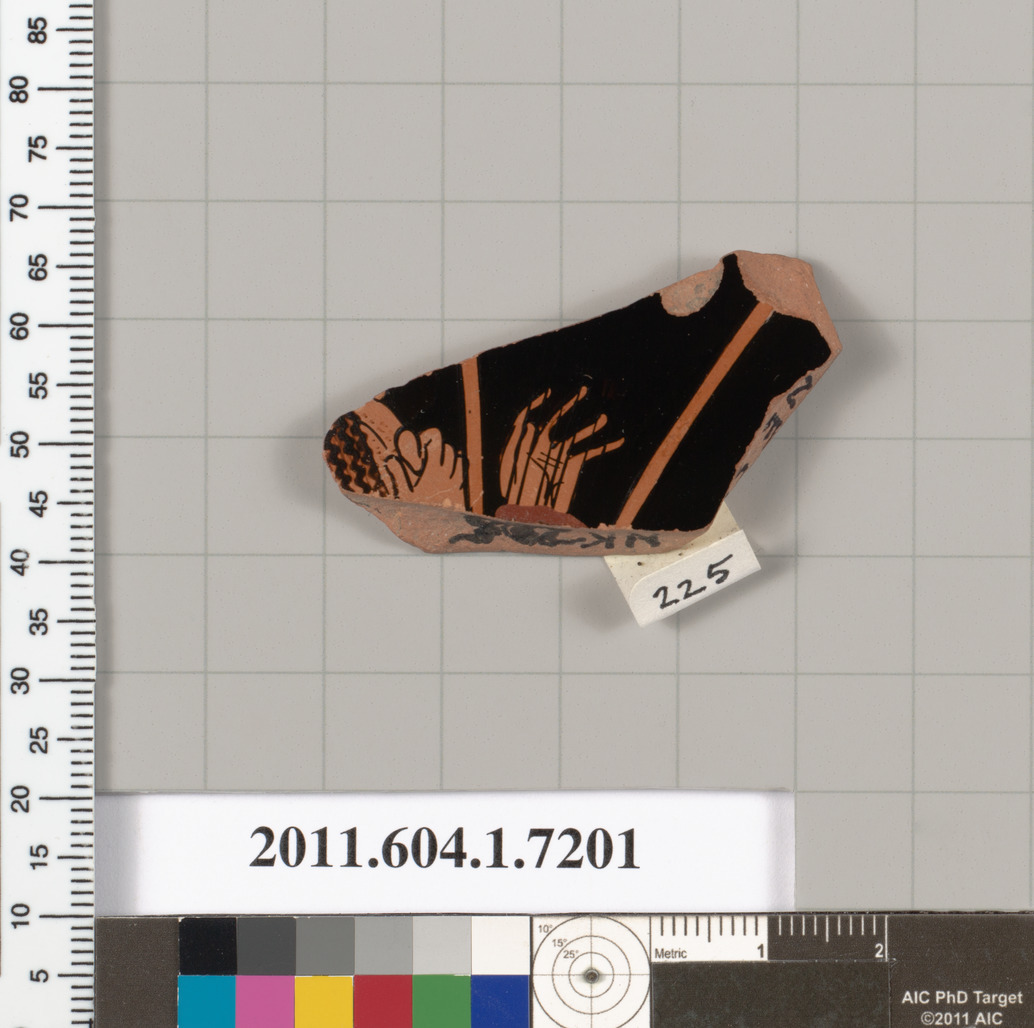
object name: kylix fragment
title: Terracotta fragment of a kylix (drinking cup)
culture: greek, attic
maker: makron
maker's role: artist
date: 500-480 BCE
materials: terracotta